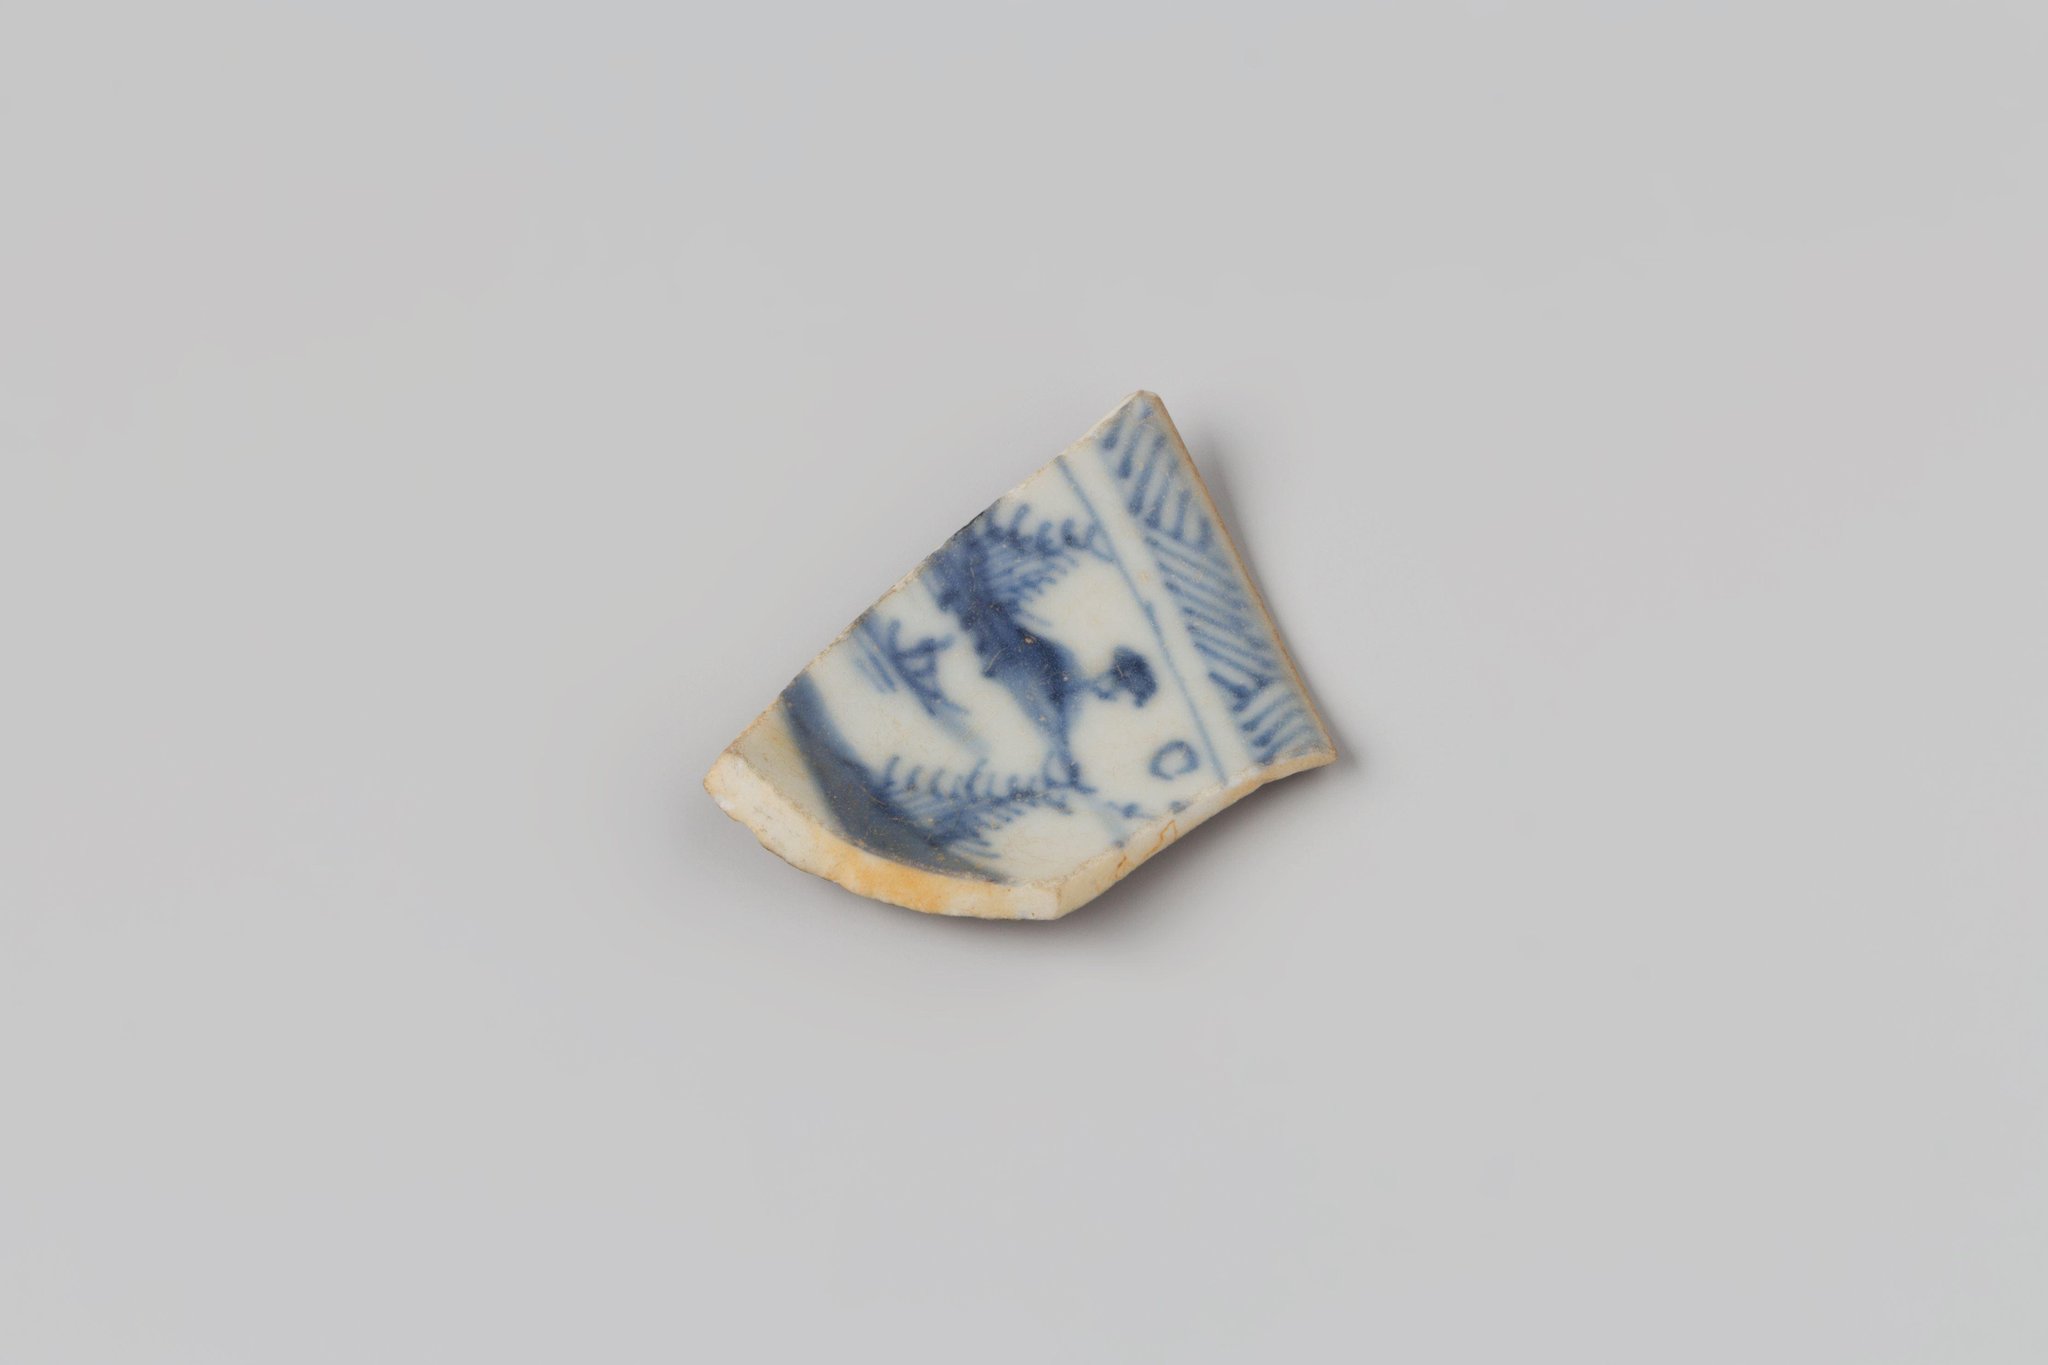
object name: sherd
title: Scherf van een kop uit het wrak van de Oost-Indiëvaarder Hollandia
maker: Anonymous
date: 1700-1743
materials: porcelain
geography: netherlands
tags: verenigde oostindische compagnie, hollandia (schip), annet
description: Porcelain, cup, type 6; fragm of body with rim, curved.